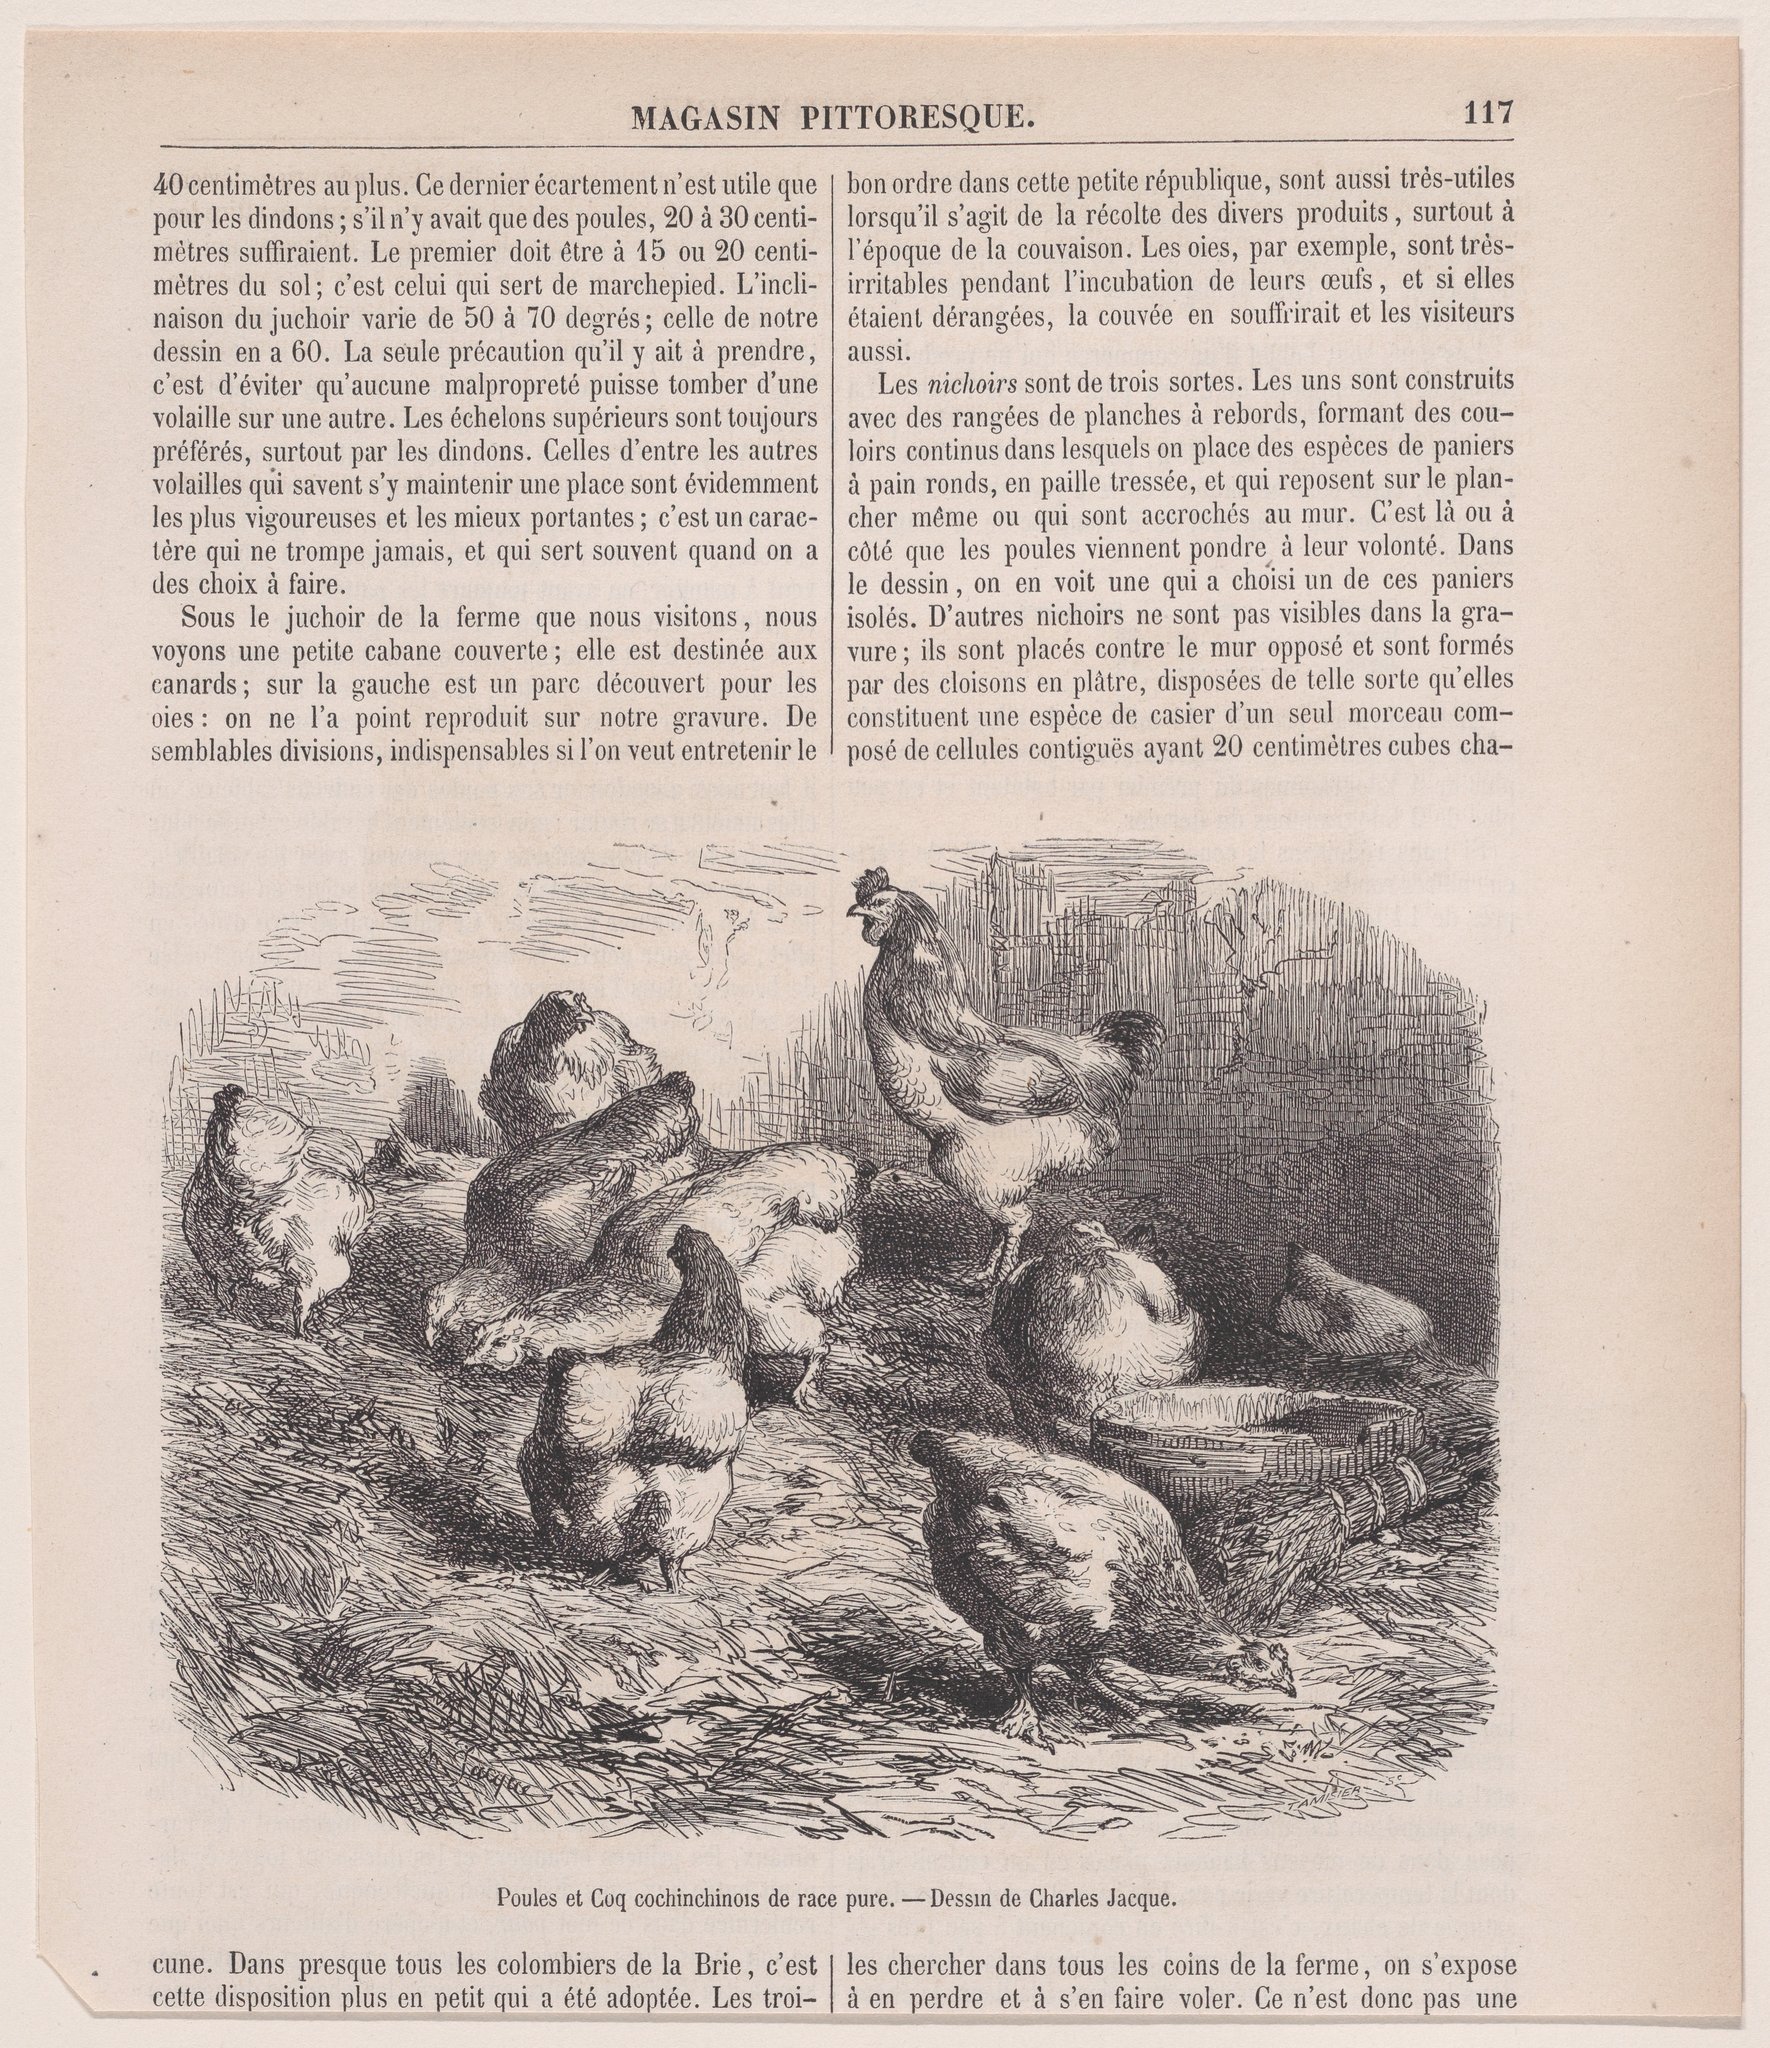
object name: print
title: Poules et Coq cochinchinois de race pure, from "Le Magasin Pittoresque"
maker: charles émile jacque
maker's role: artist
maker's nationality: french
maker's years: 1813-1894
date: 1852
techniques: engraving